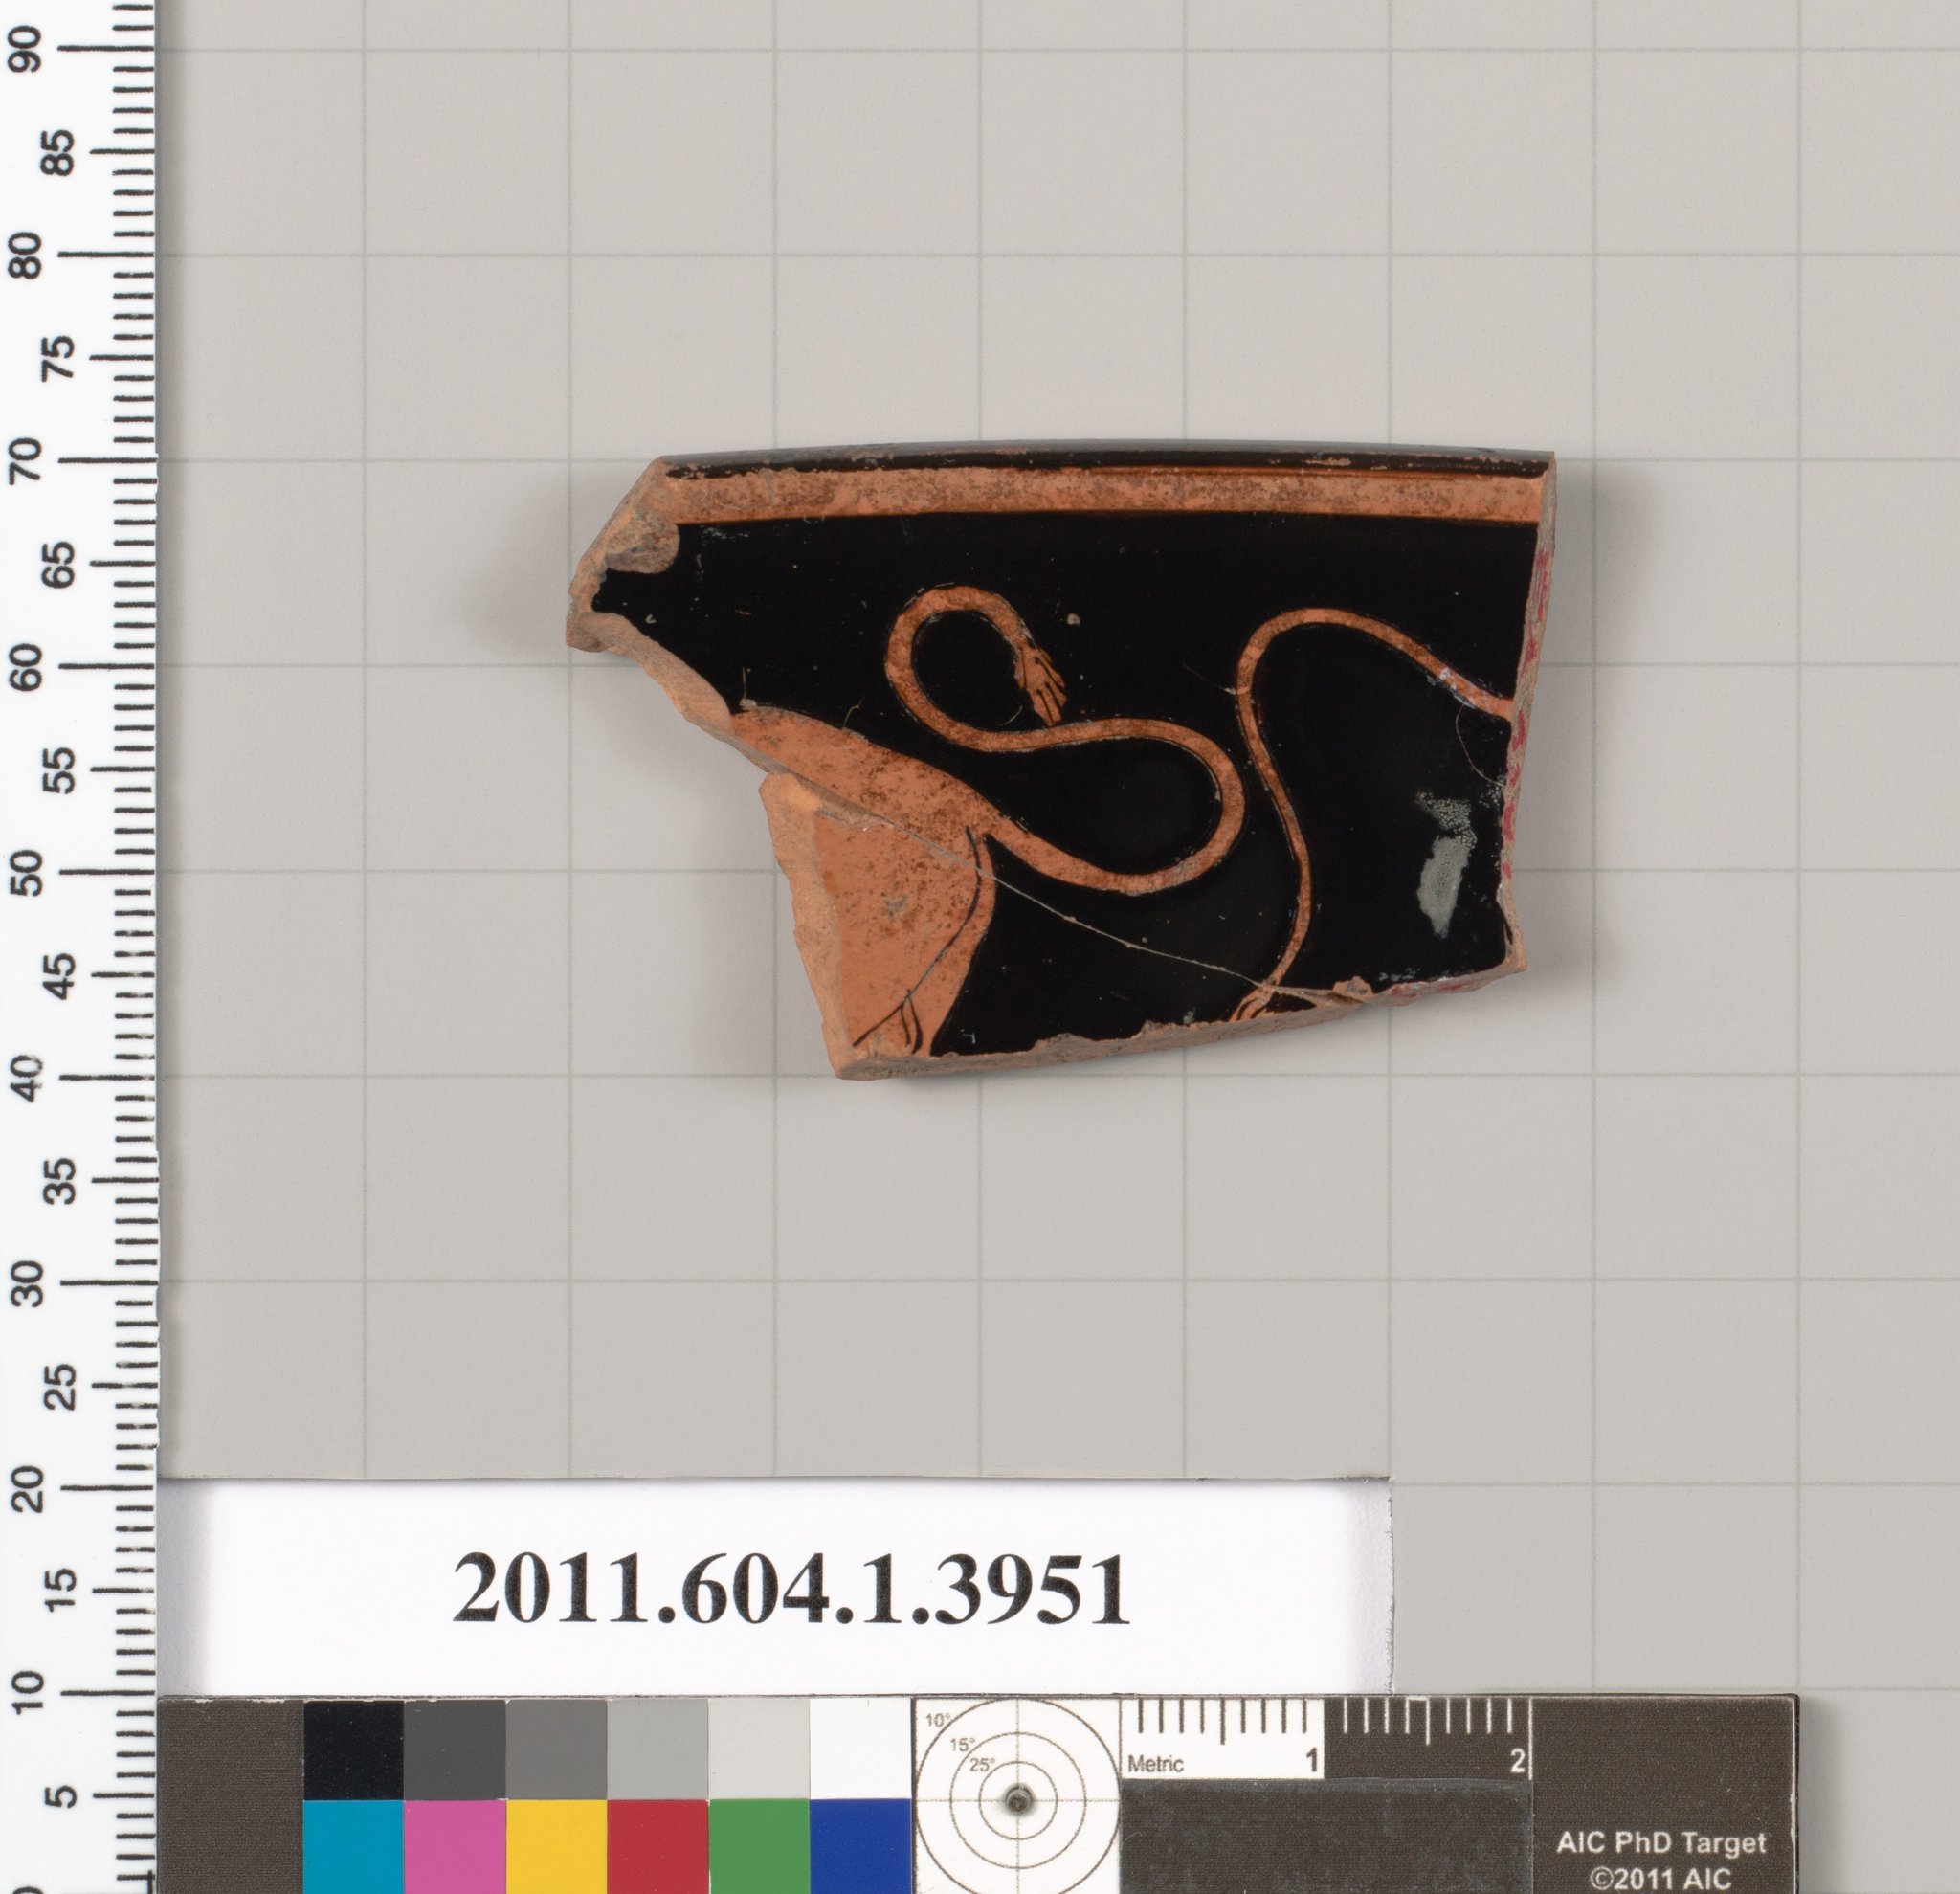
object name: kylix fragment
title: Terracotta rim fragment of a kylix (drinking cup)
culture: greek, attic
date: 500-476 BCE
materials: terracotta